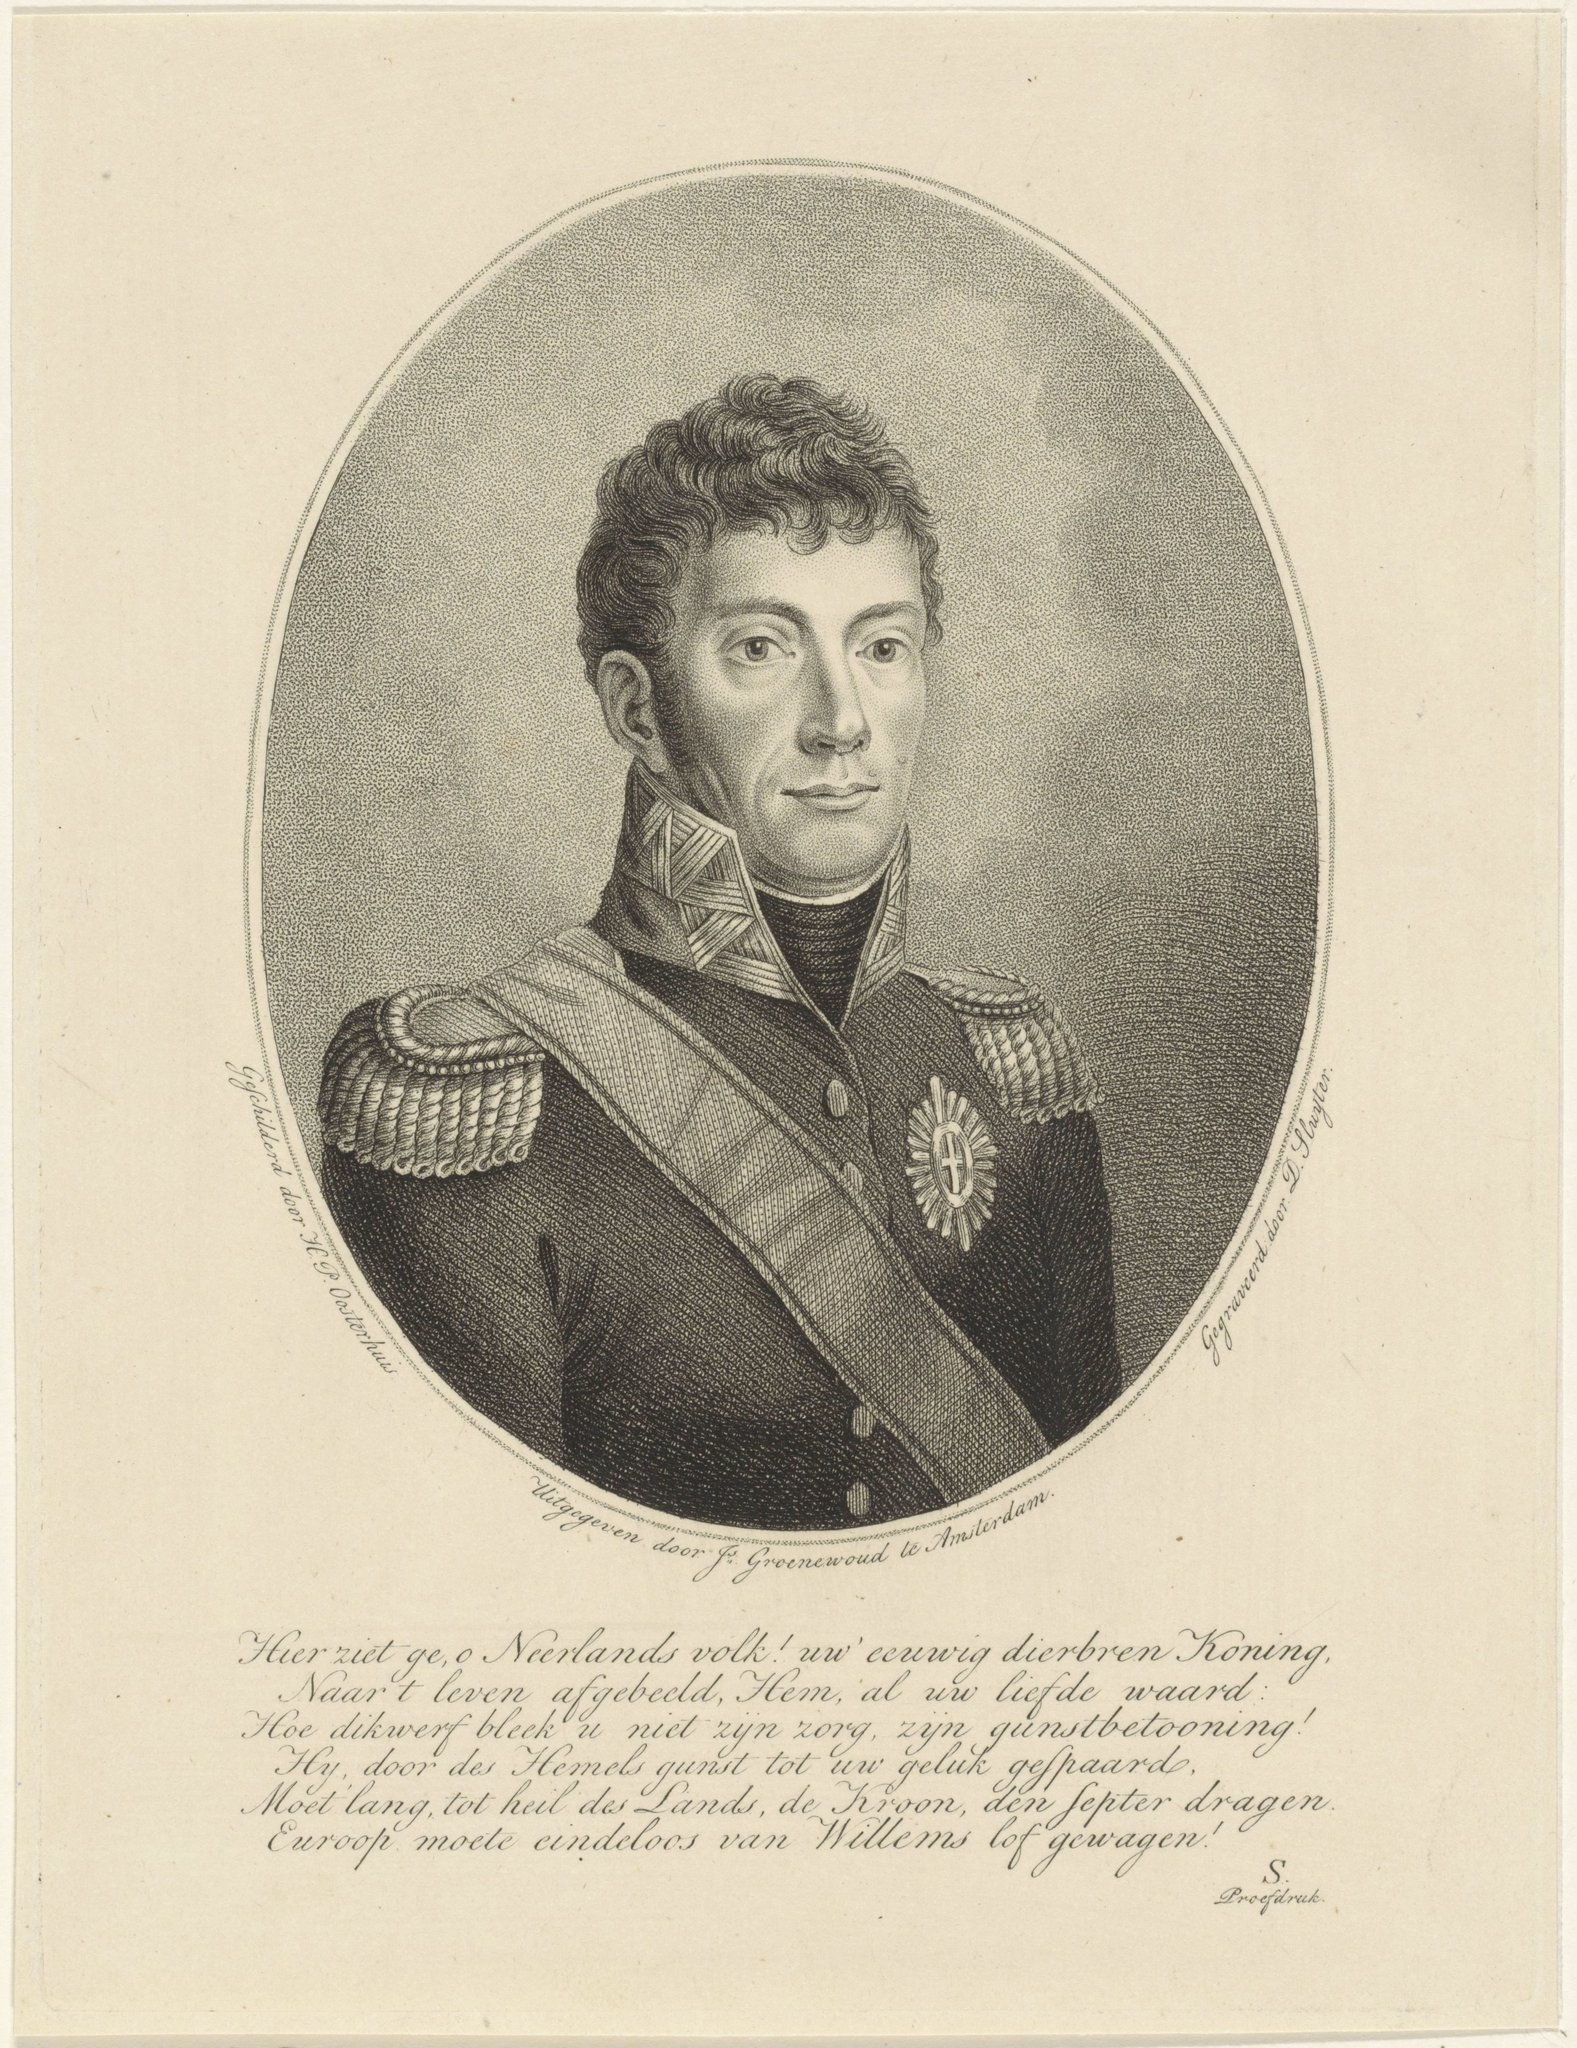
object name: print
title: Portret van Willem I Frederik, koning der Nederlanden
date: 1815-1819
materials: paper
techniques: engraving, etching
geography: amsterdam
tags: the hague, berlin, william i of the netherlands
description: De hier vermelde titel verwijst naar de hoogst verkregen titel van de geportretteerde, niet per se naar de titel die de geportretteerde op deze voorstelling draagt.